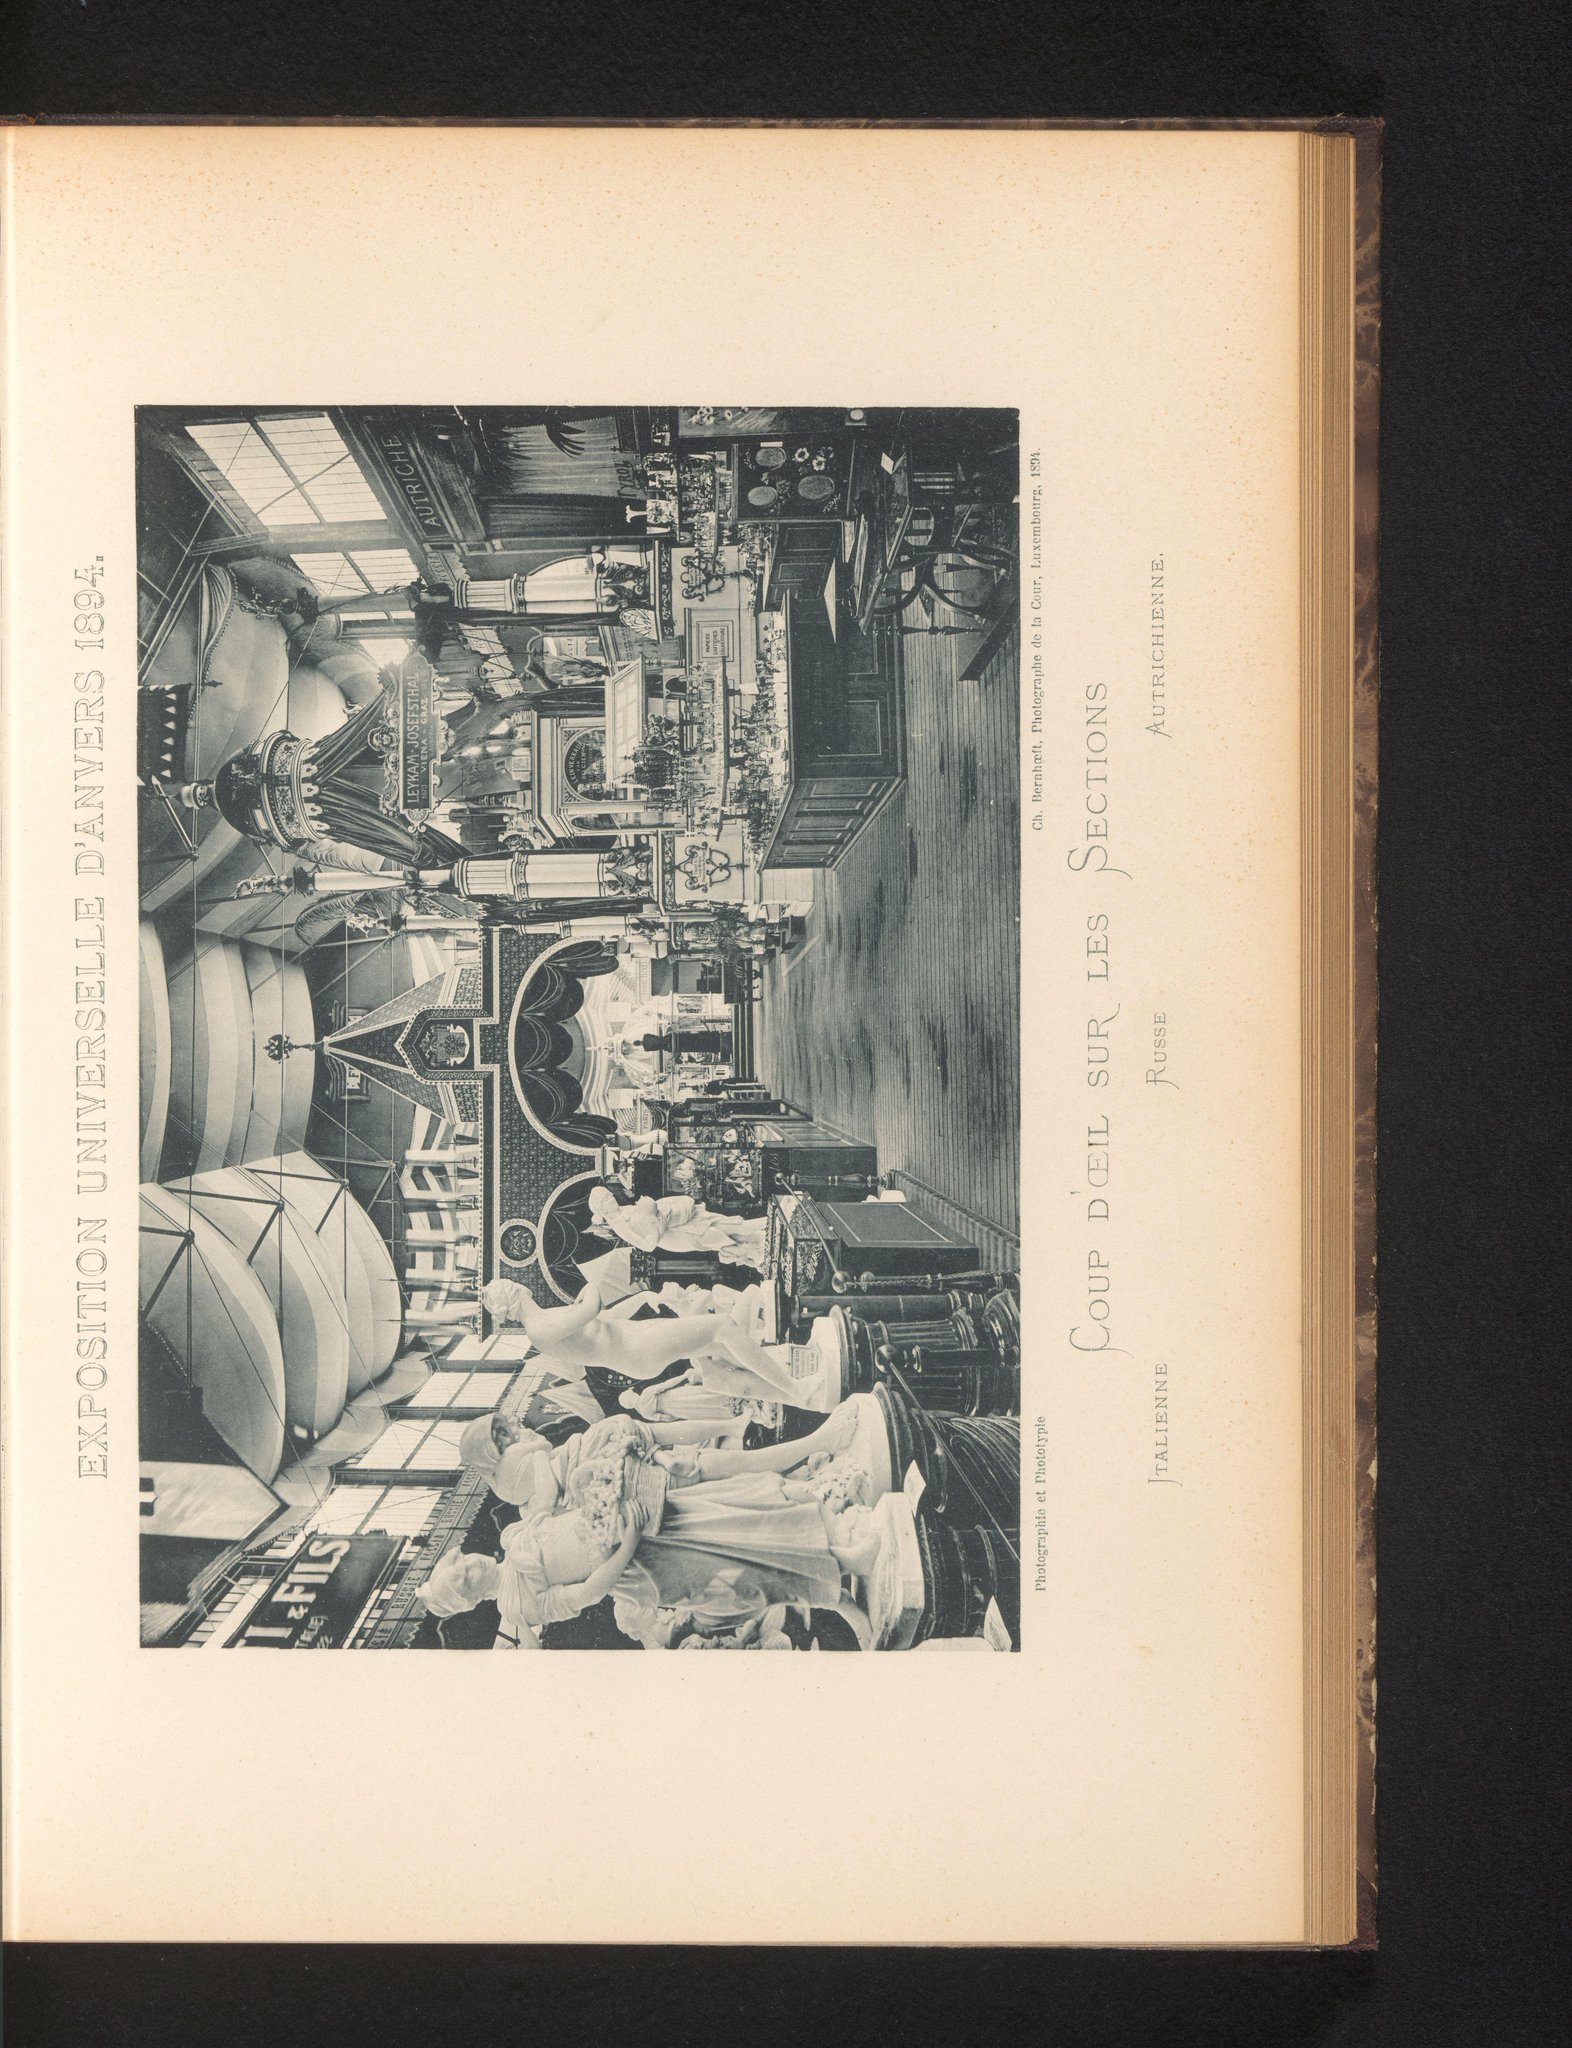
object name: photomechanical print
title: Gezicht op de Italiaanse, Russische en Oostenrijkse delen van de hoofdtentoonstelling van de Wereldtentoonstelling van Antwerpen in 1894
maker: charles bernhoeft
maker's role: publisher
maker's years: 1859-1933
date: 1894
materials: paper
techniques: photograph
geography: luxembourg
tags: world fair, world exhibition, piece of sculpture, reproduction of a piece of sculpture, antwerp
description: Prent op derde ongenummerde pagina na pagina 34.